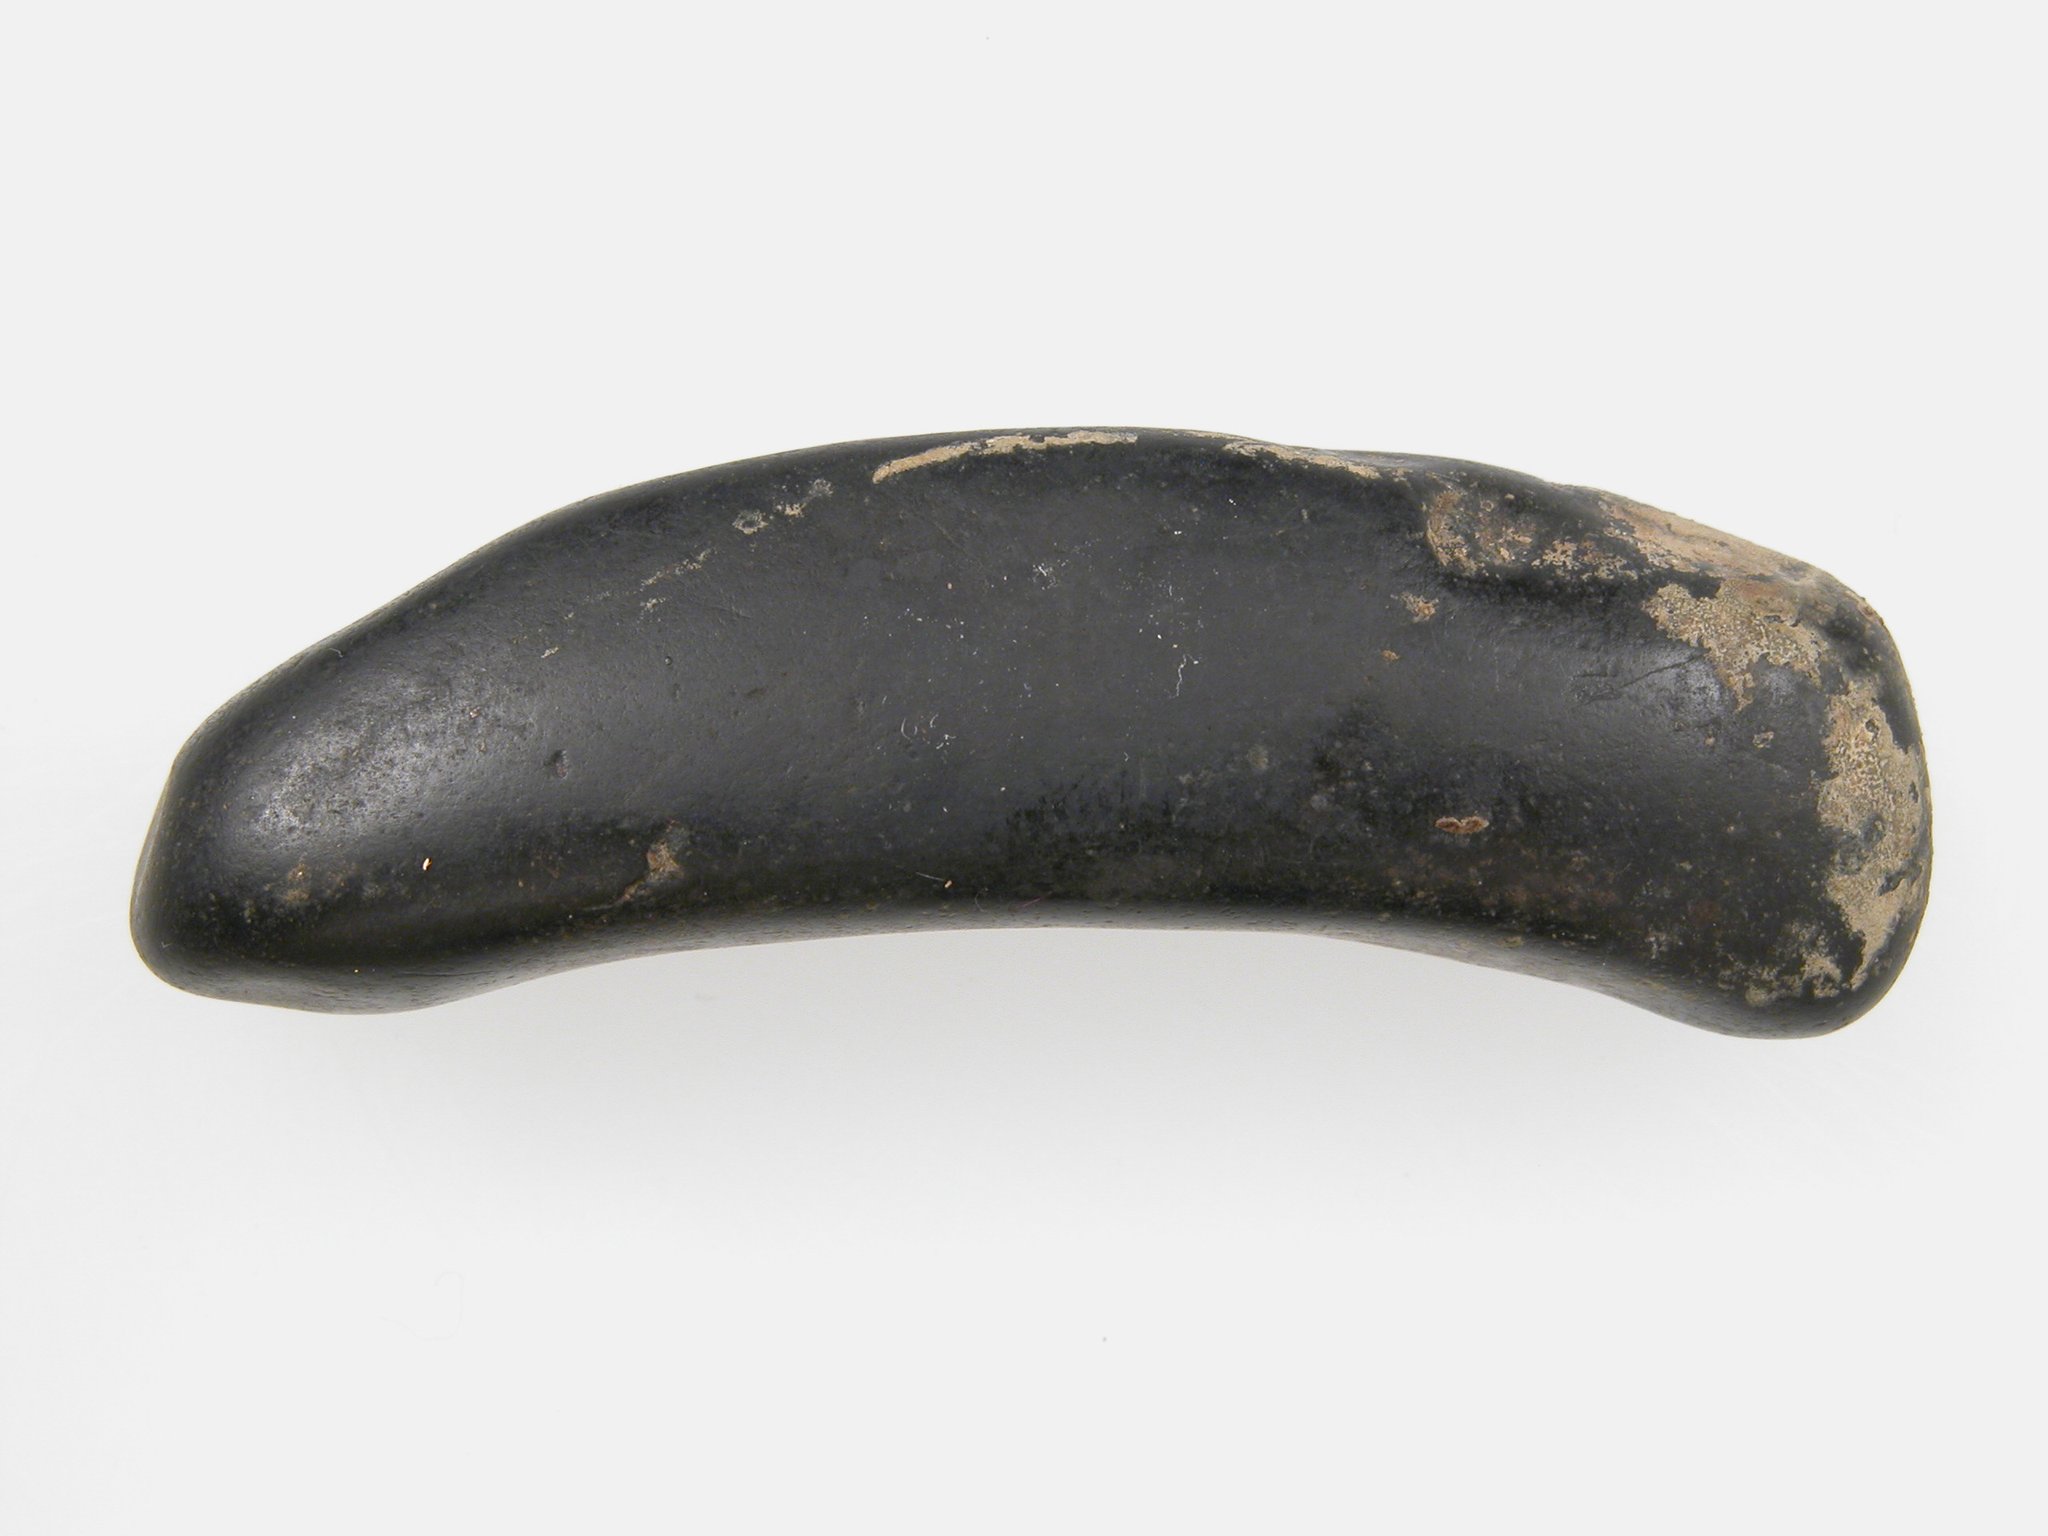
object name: necklace, bead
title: Neolithic Amulet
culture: neolithic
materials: stone